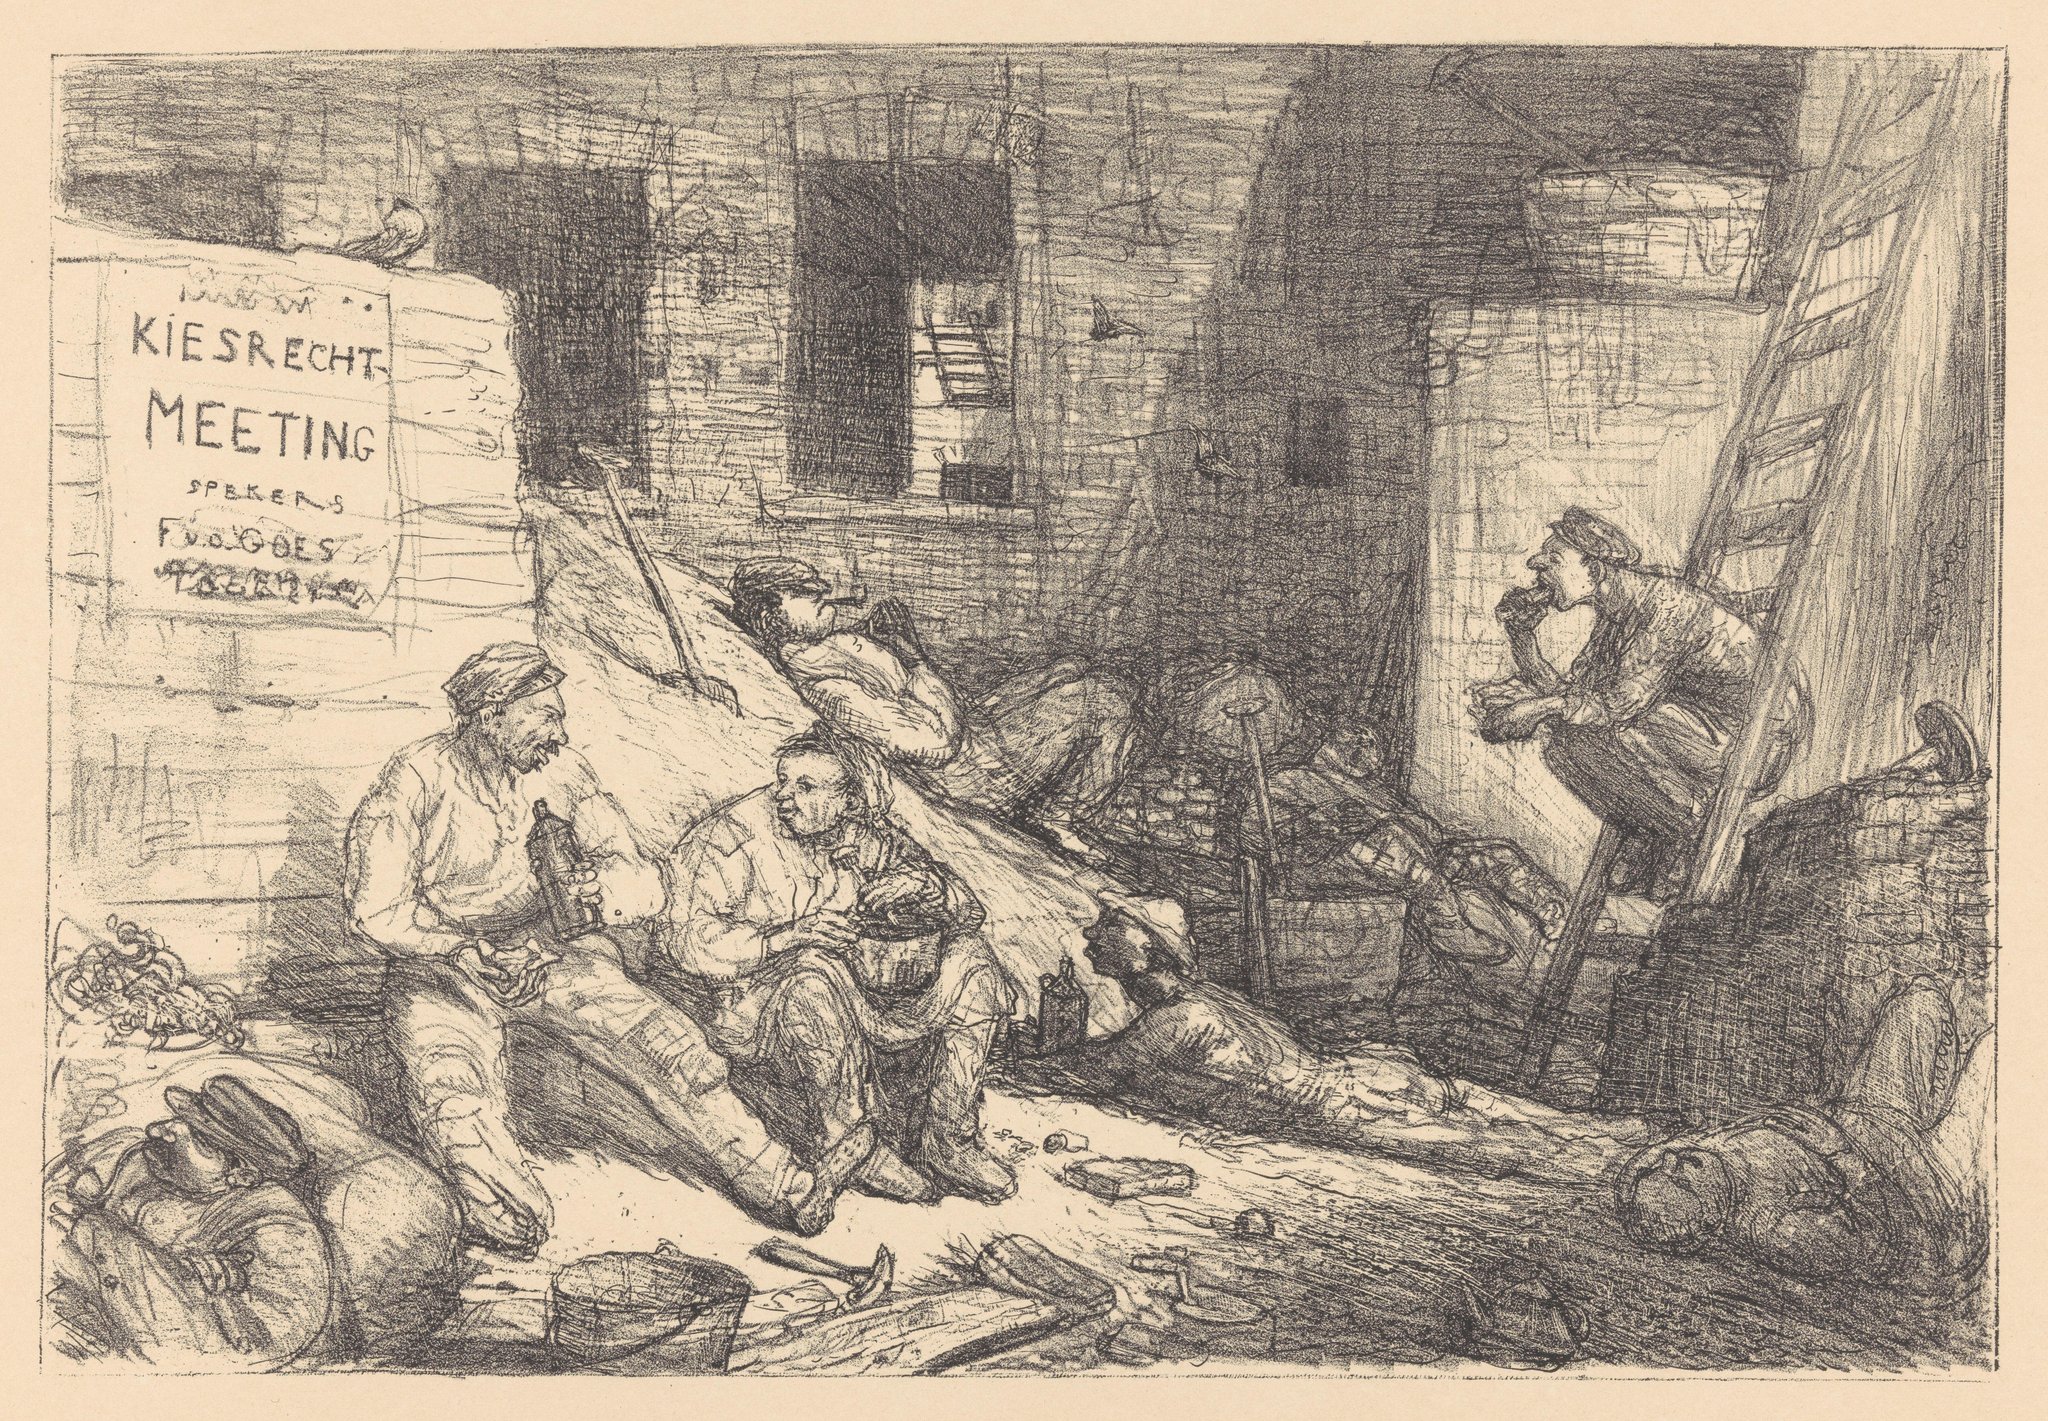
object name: cartoon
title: Hollandsch-kiesrecht-agitatie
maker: marius bauer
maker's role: draughtsman, print maker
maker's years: 1867-1932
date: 1896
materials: paper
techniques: lithograph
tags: amsterdam, frank van der goes, political caricatures and satires, netherlands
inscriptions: collector's mark: Lugt 2228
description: Spotprent op de geringe belangstelling onder de werkende klasse voor de herziening van het kiesrecht in 1896. Schaftende arbeiders onder een aanplakbiljet voor een meeting over het kiesrecht met Frank van der Goes als spreker. Verschenen in het bijvoegsel van 'De Kroniek' van 29 maart 1896.